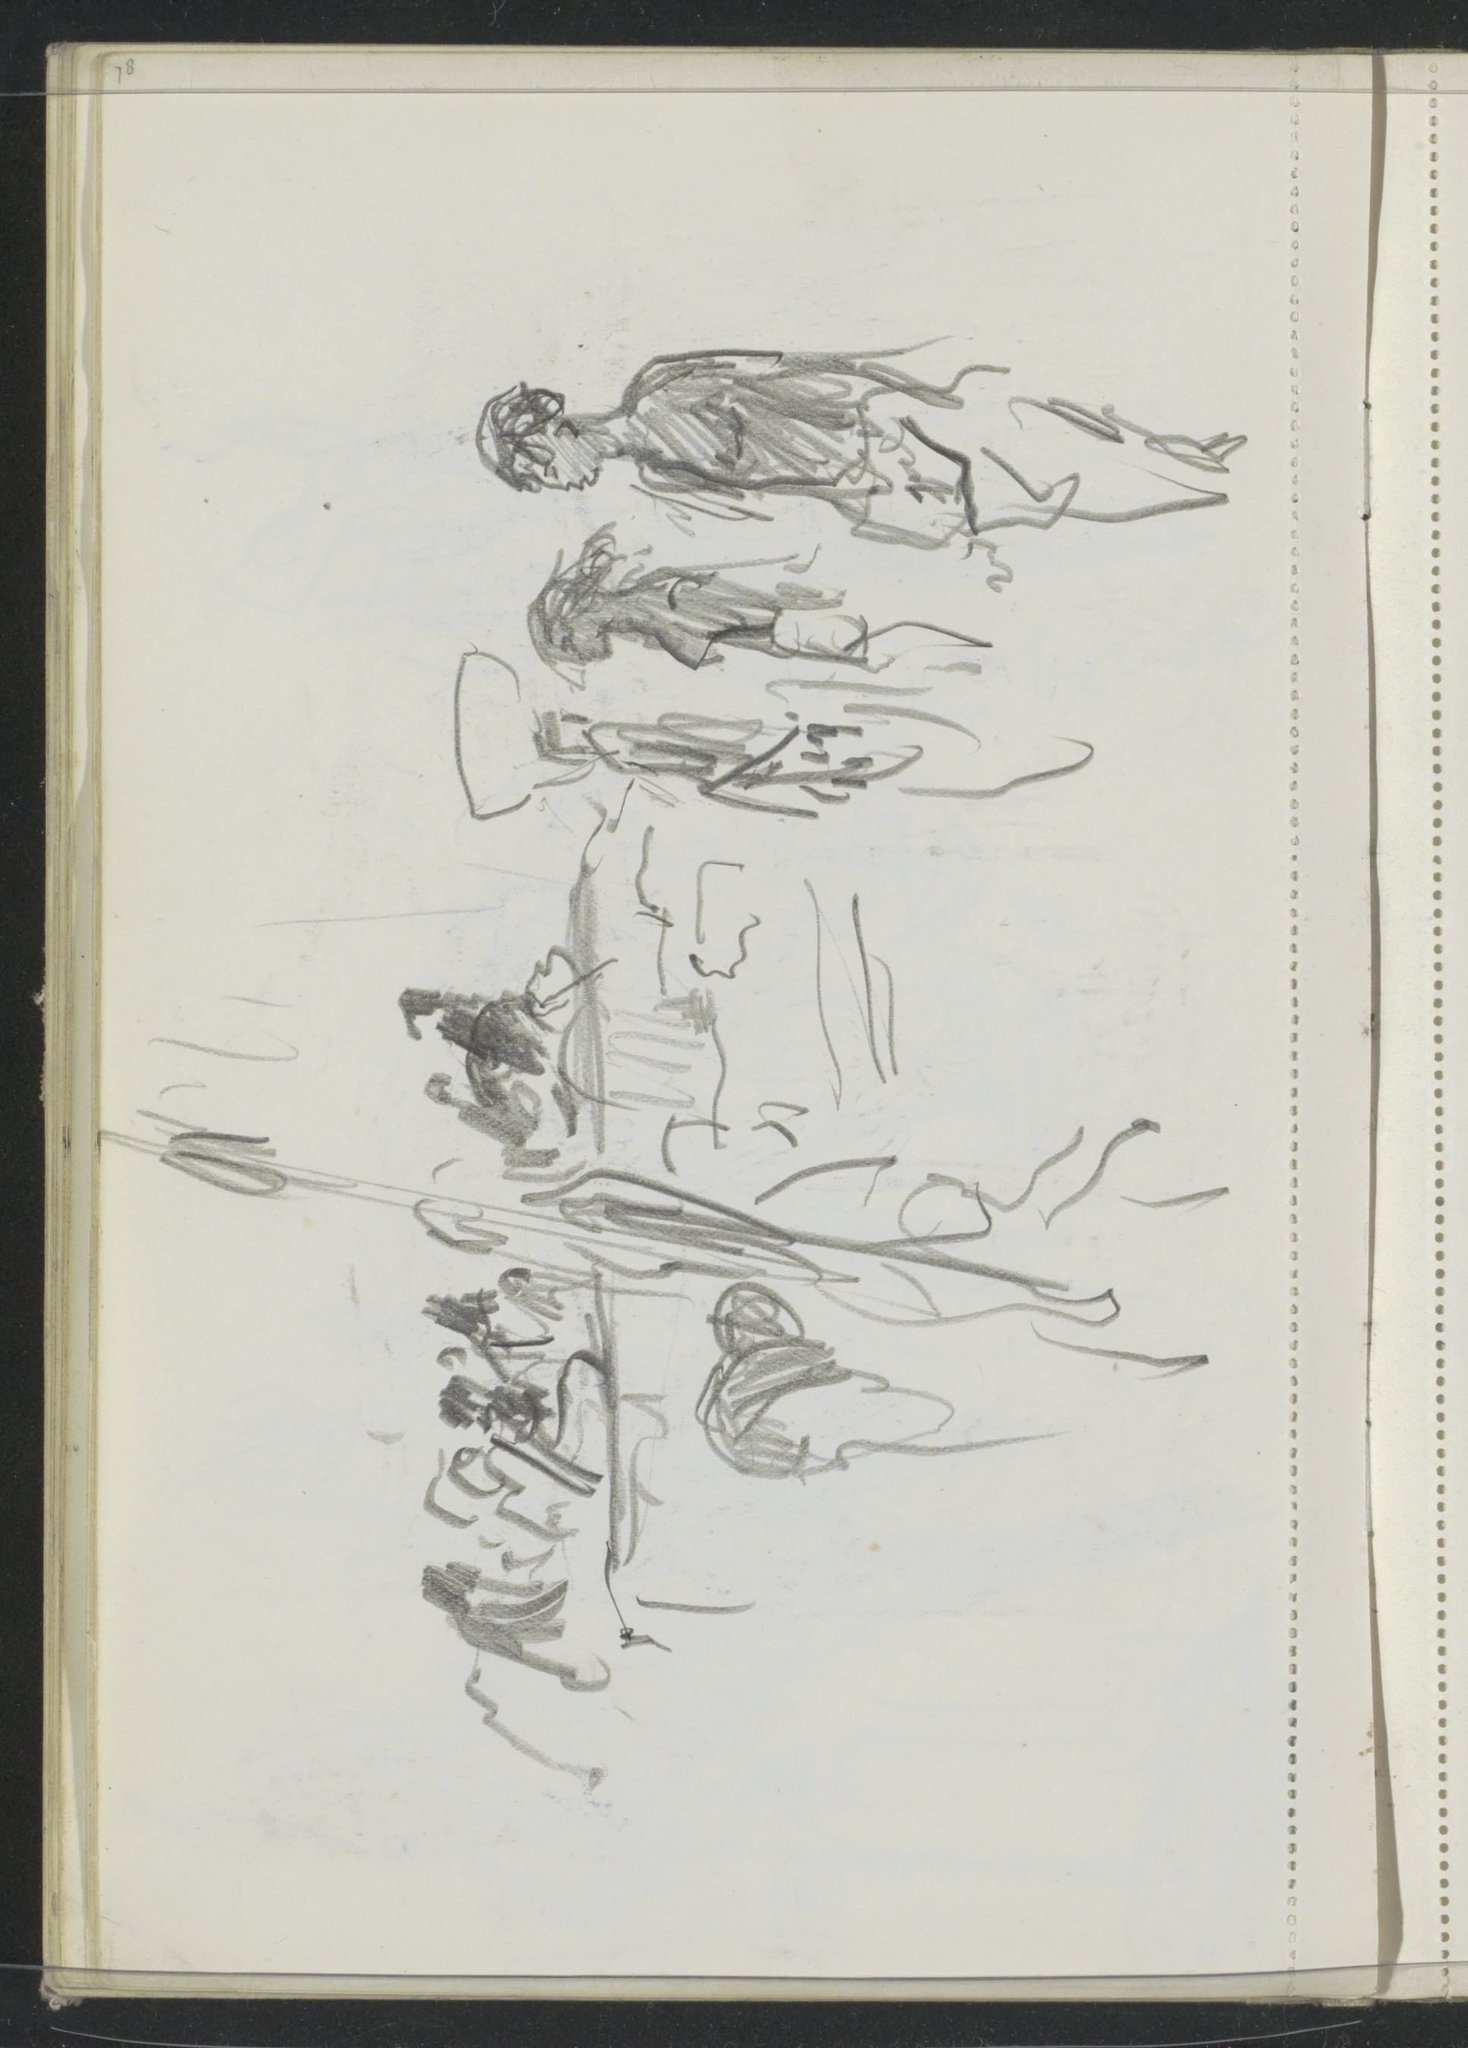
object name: sketchbook leaf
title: Figuren in een optocht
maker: marius bauer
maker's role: draughtsman, print maker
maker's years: 1867-1932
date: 1925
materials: paper, pencil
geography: indonesia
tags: asiatic races and peoples, walking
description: Pagina 78 uit een schetsboek met 74 bladen.